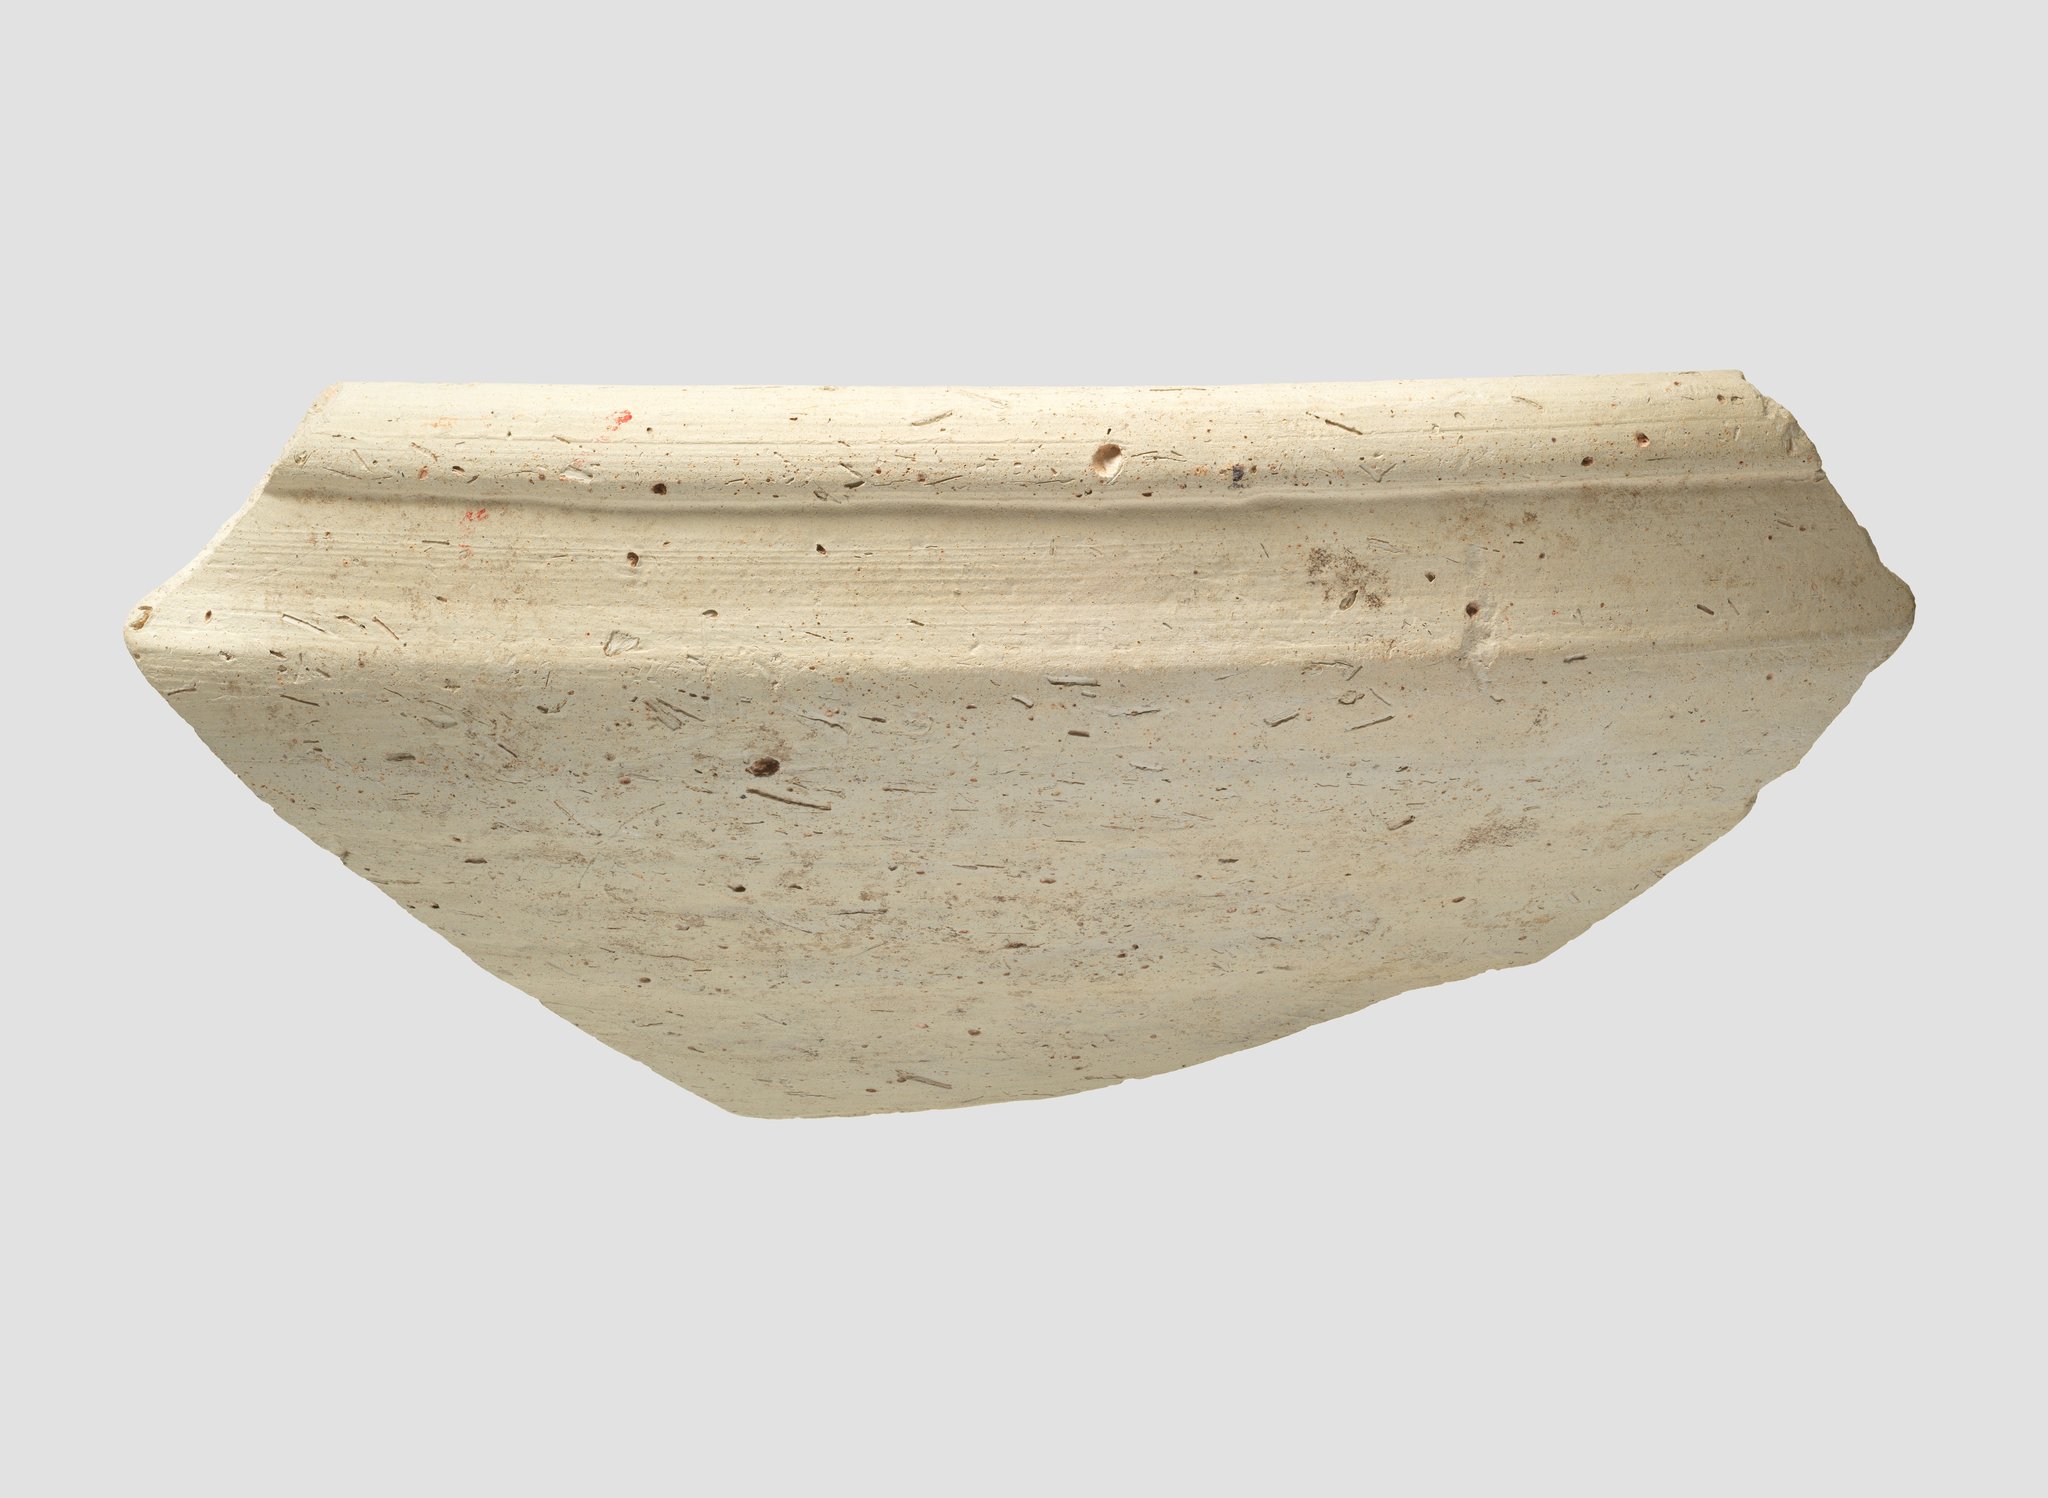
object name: bowl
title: Bowl rim sherd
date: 2333-2001 BCE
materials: ceramic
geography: mesopotamia